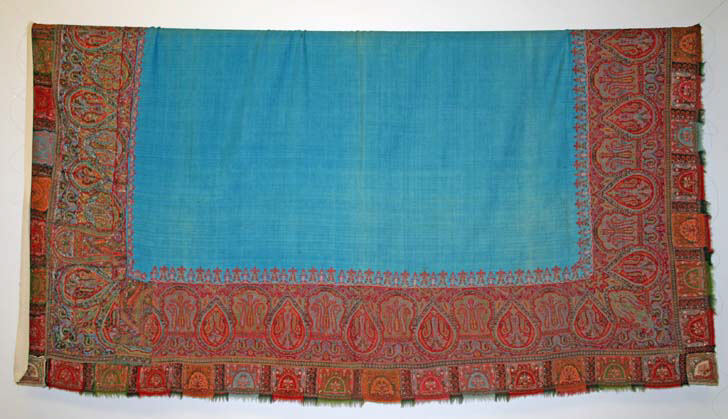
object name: shawl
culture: indian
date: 1860